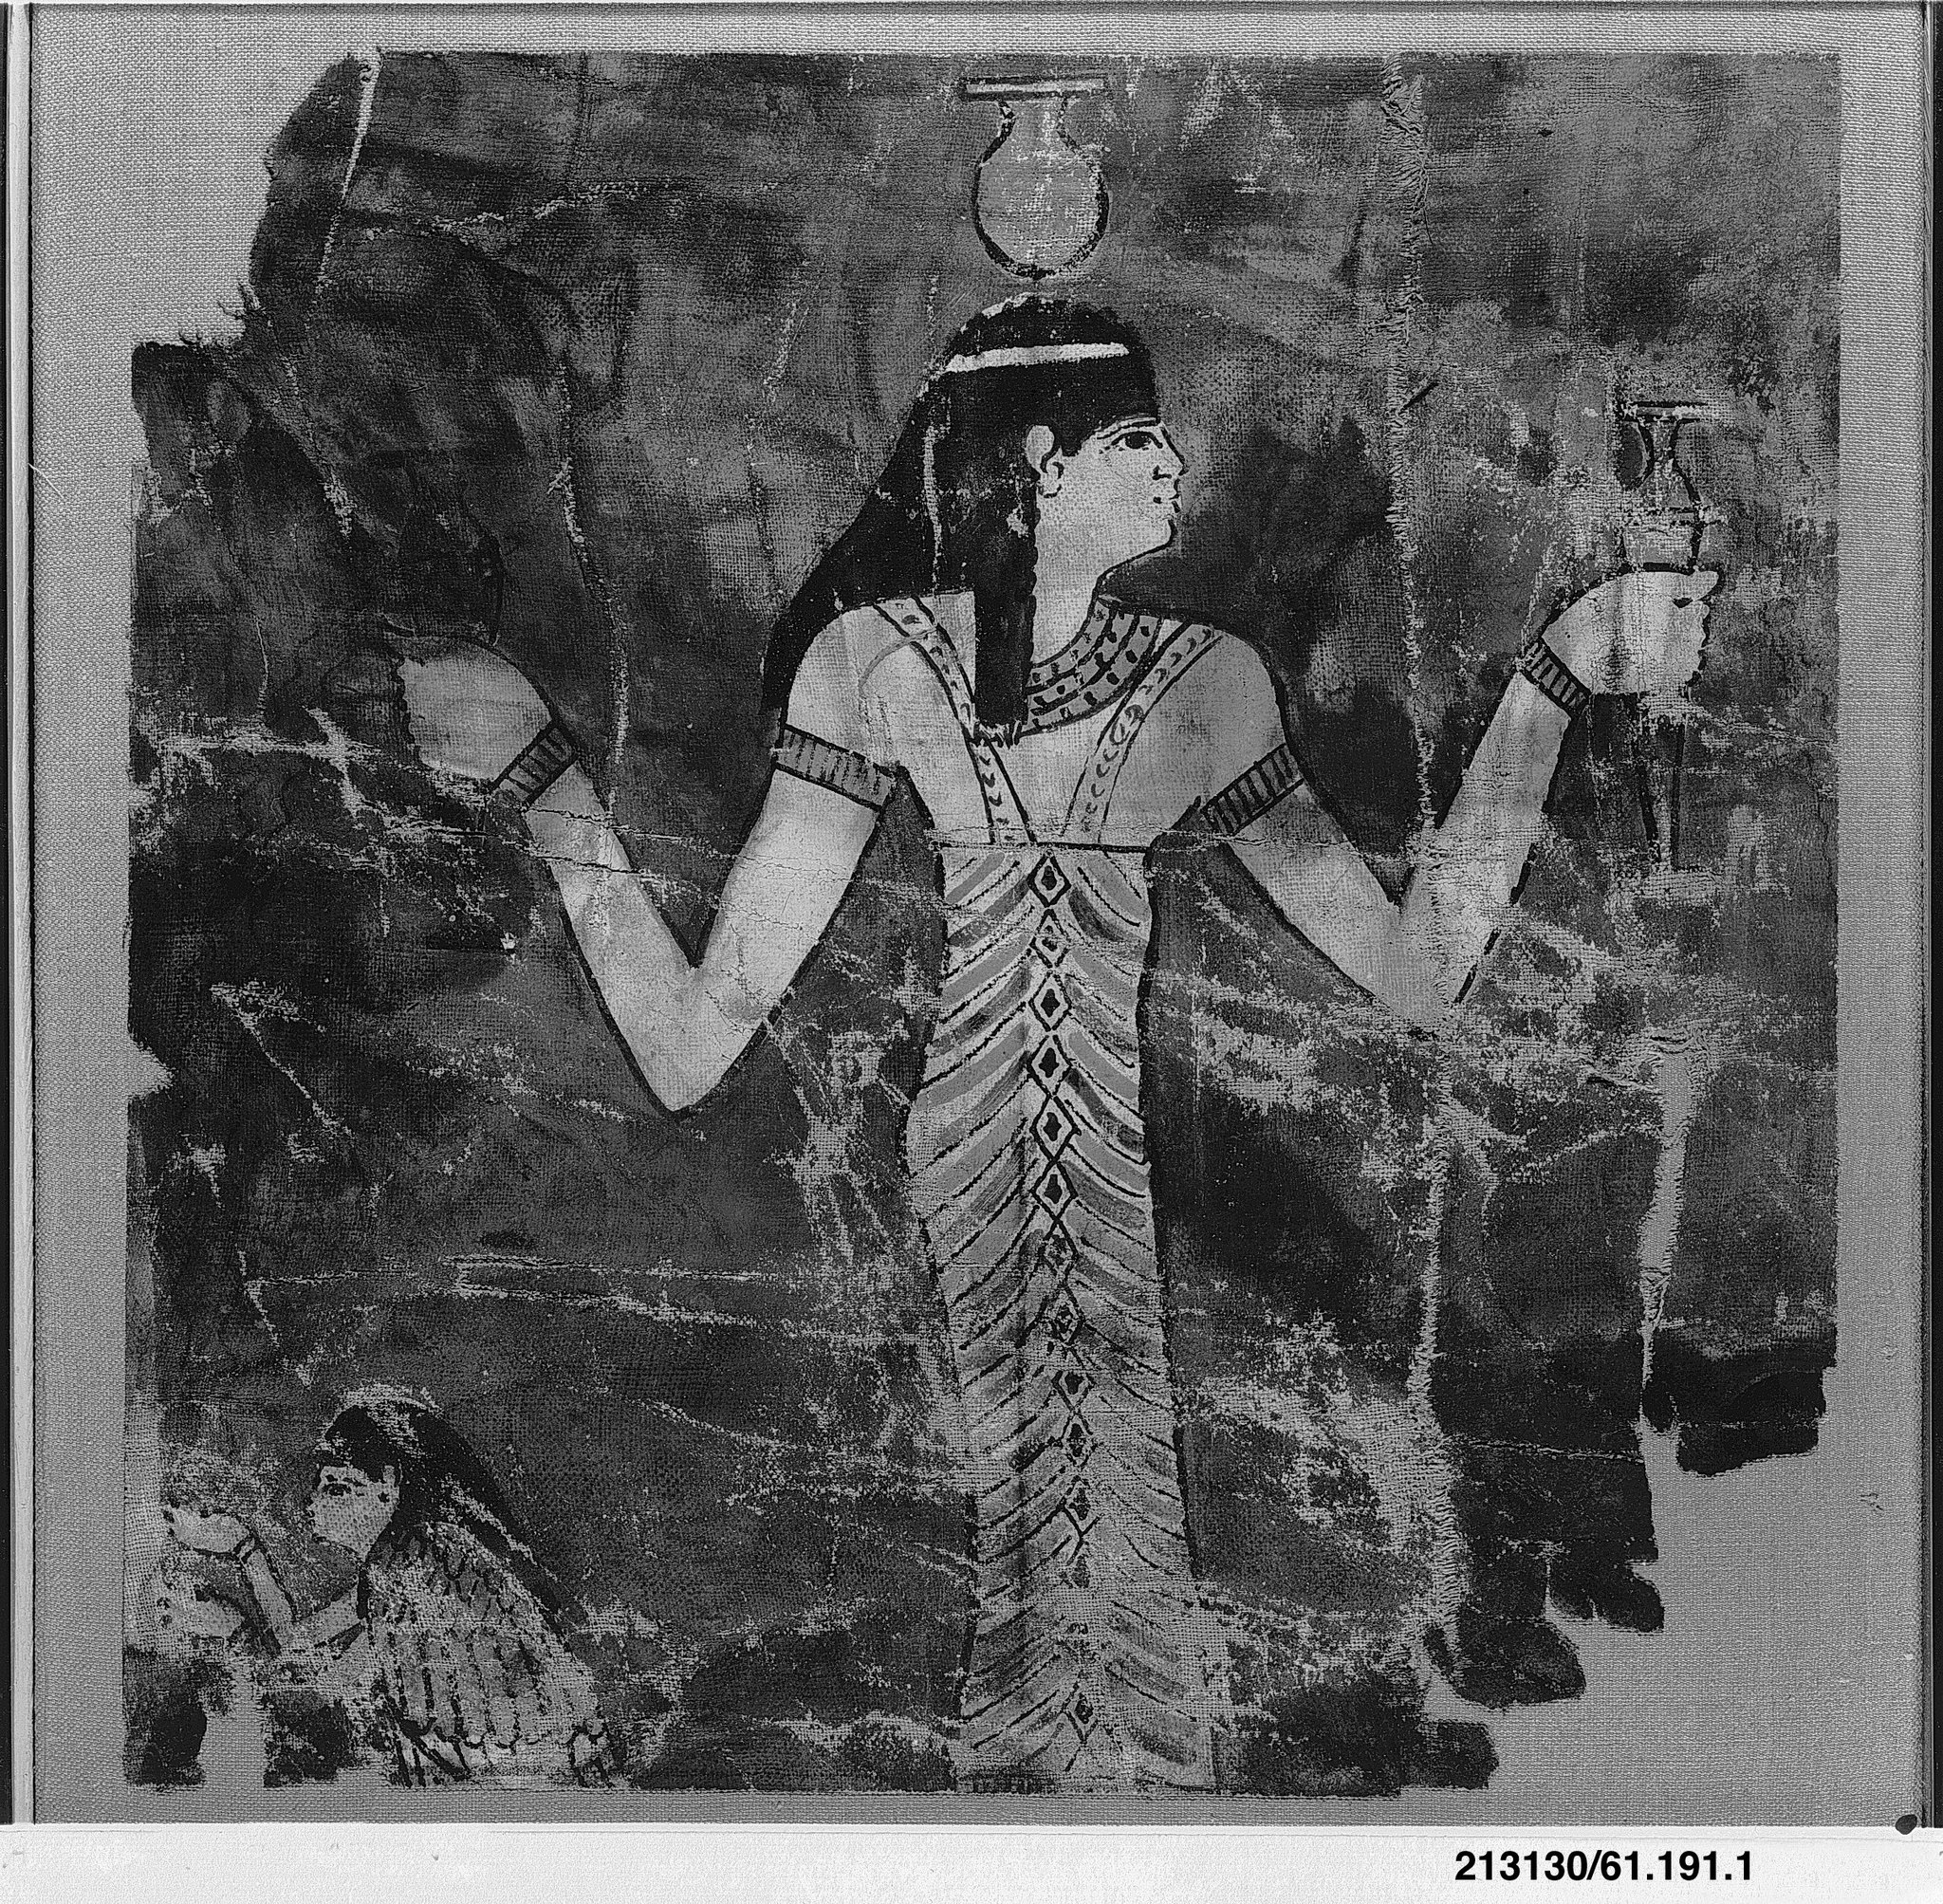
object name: shroud, woman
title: Fragment of a linen shroud painting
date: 1-100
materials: gesso, linen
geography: egypt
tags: men,women